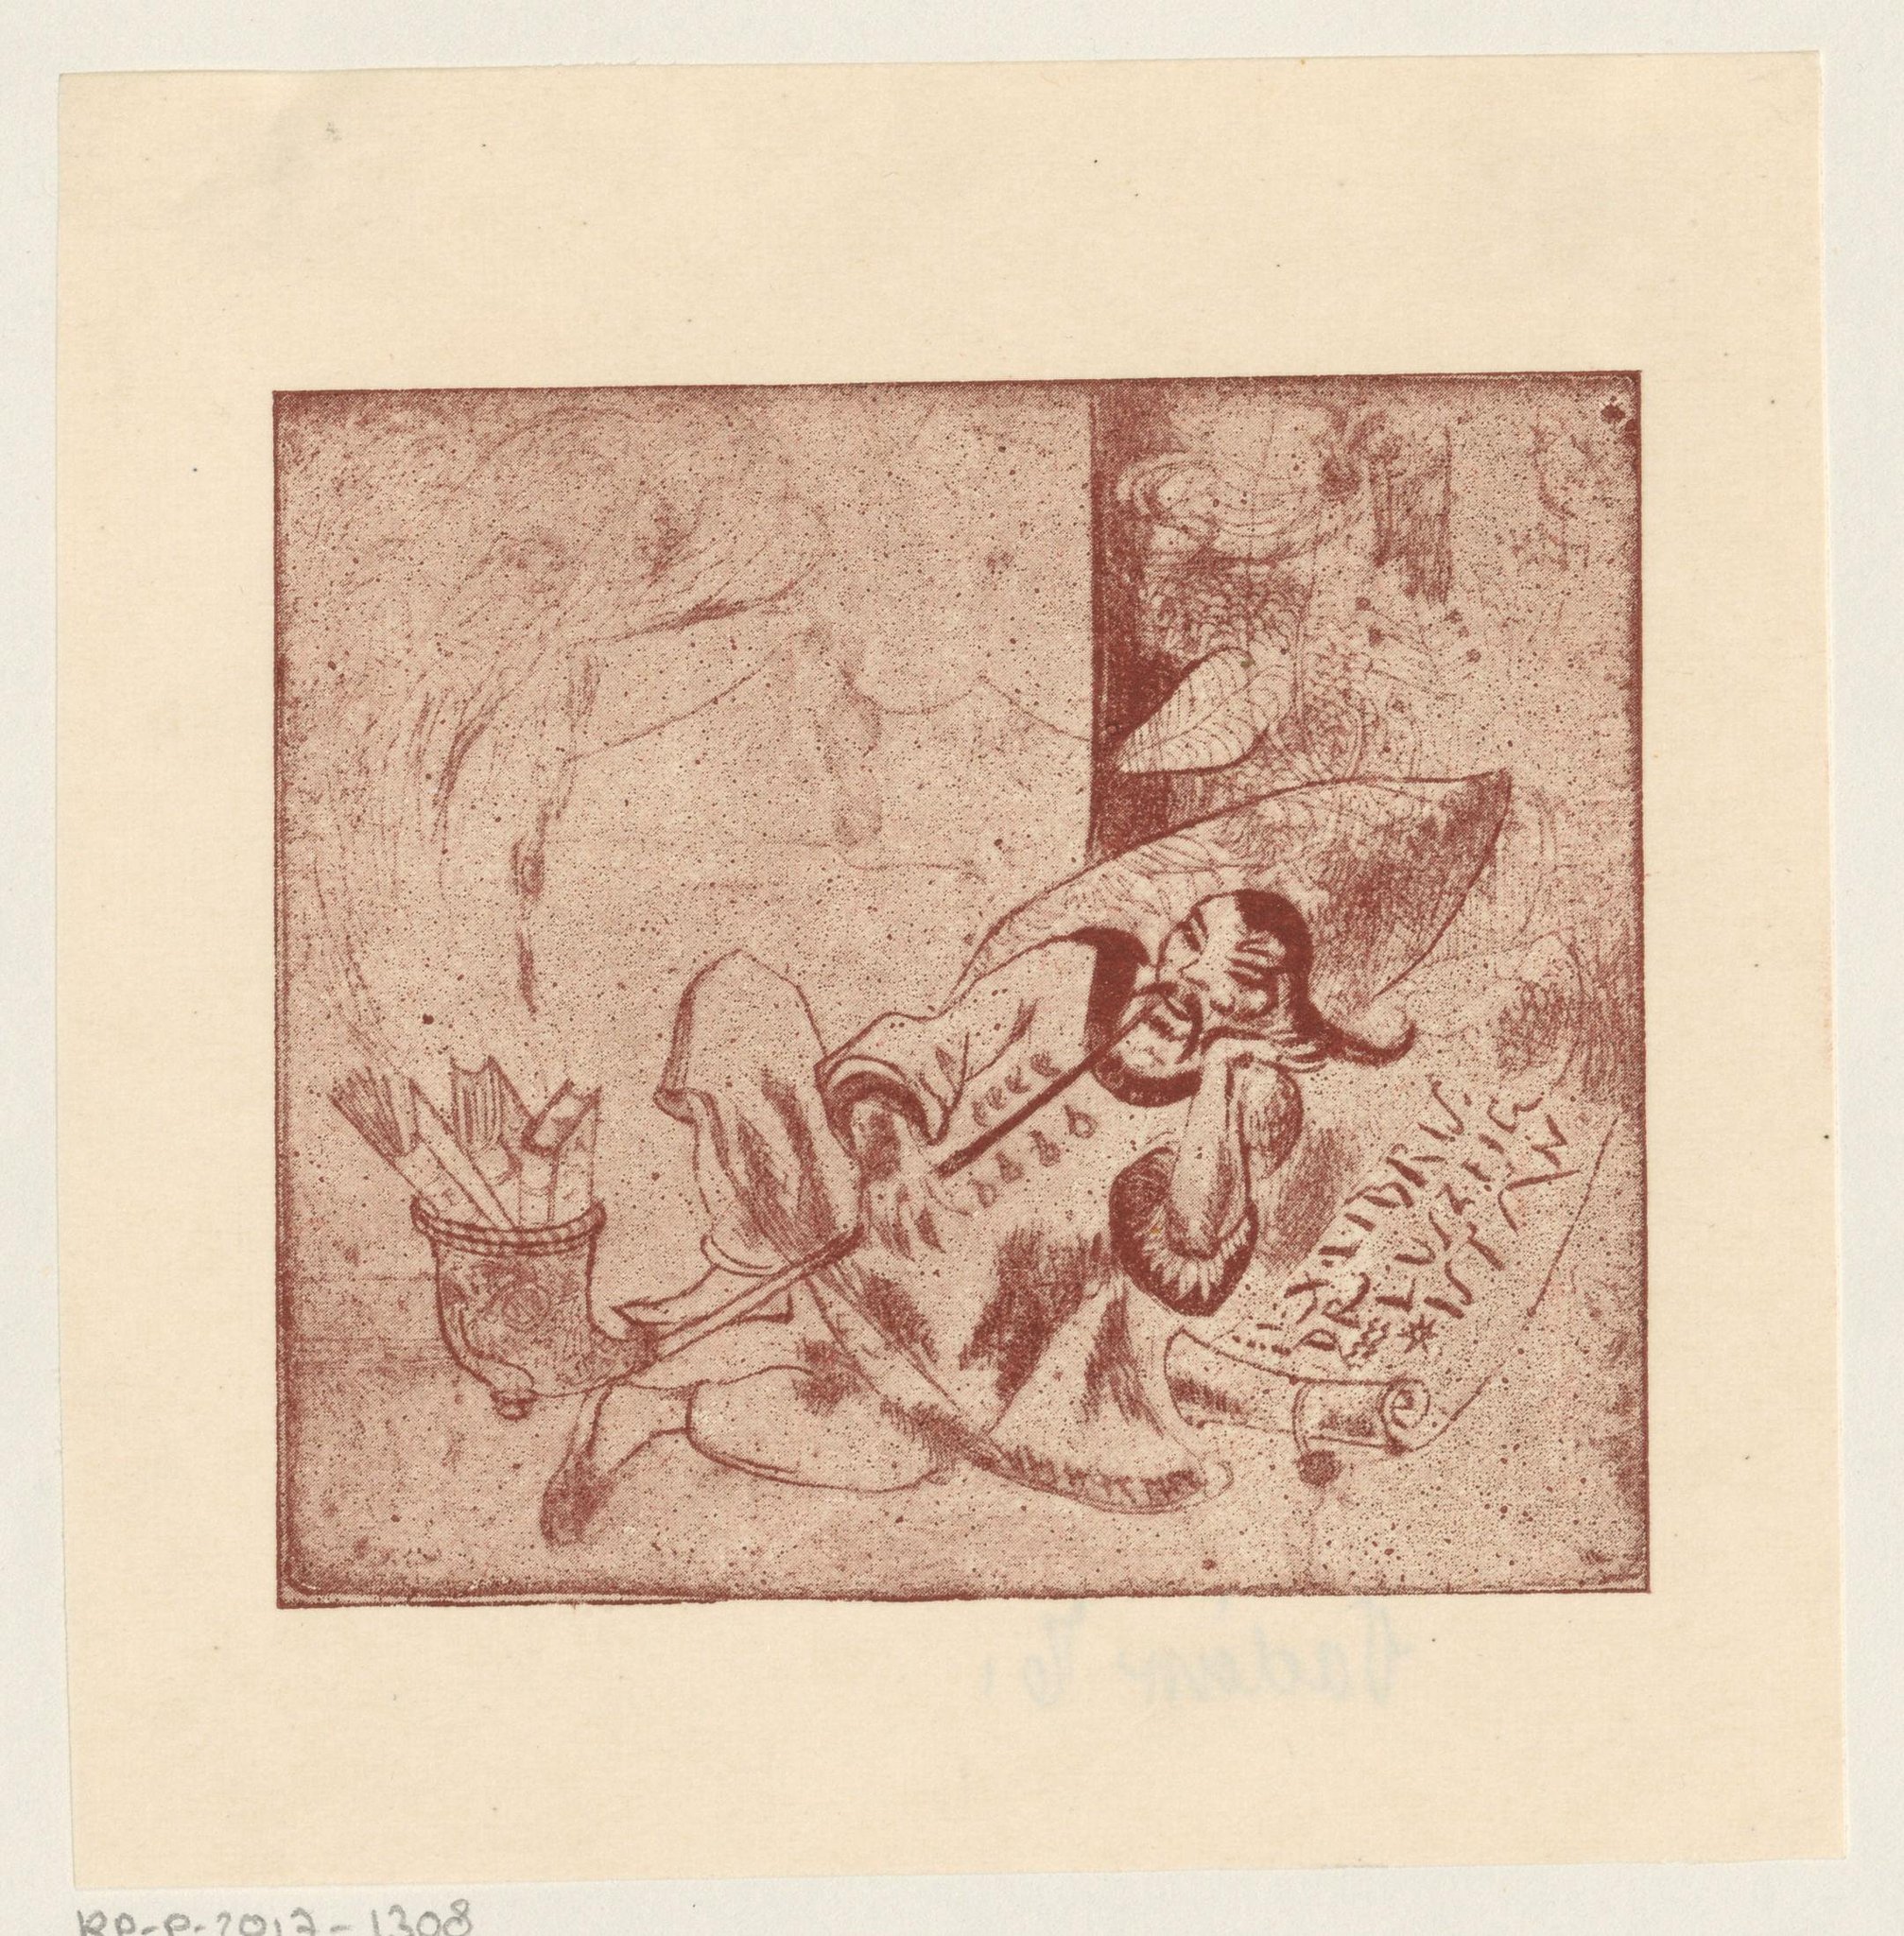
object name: photomechanical print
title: Ex libris van István Lusztig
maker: Anonymous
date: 1913-1944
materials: paper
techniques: autotype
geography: hungary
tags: chinese, opium-pipe, book, lying figure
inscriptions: inscription: ‘Vadász b 1 (?)’